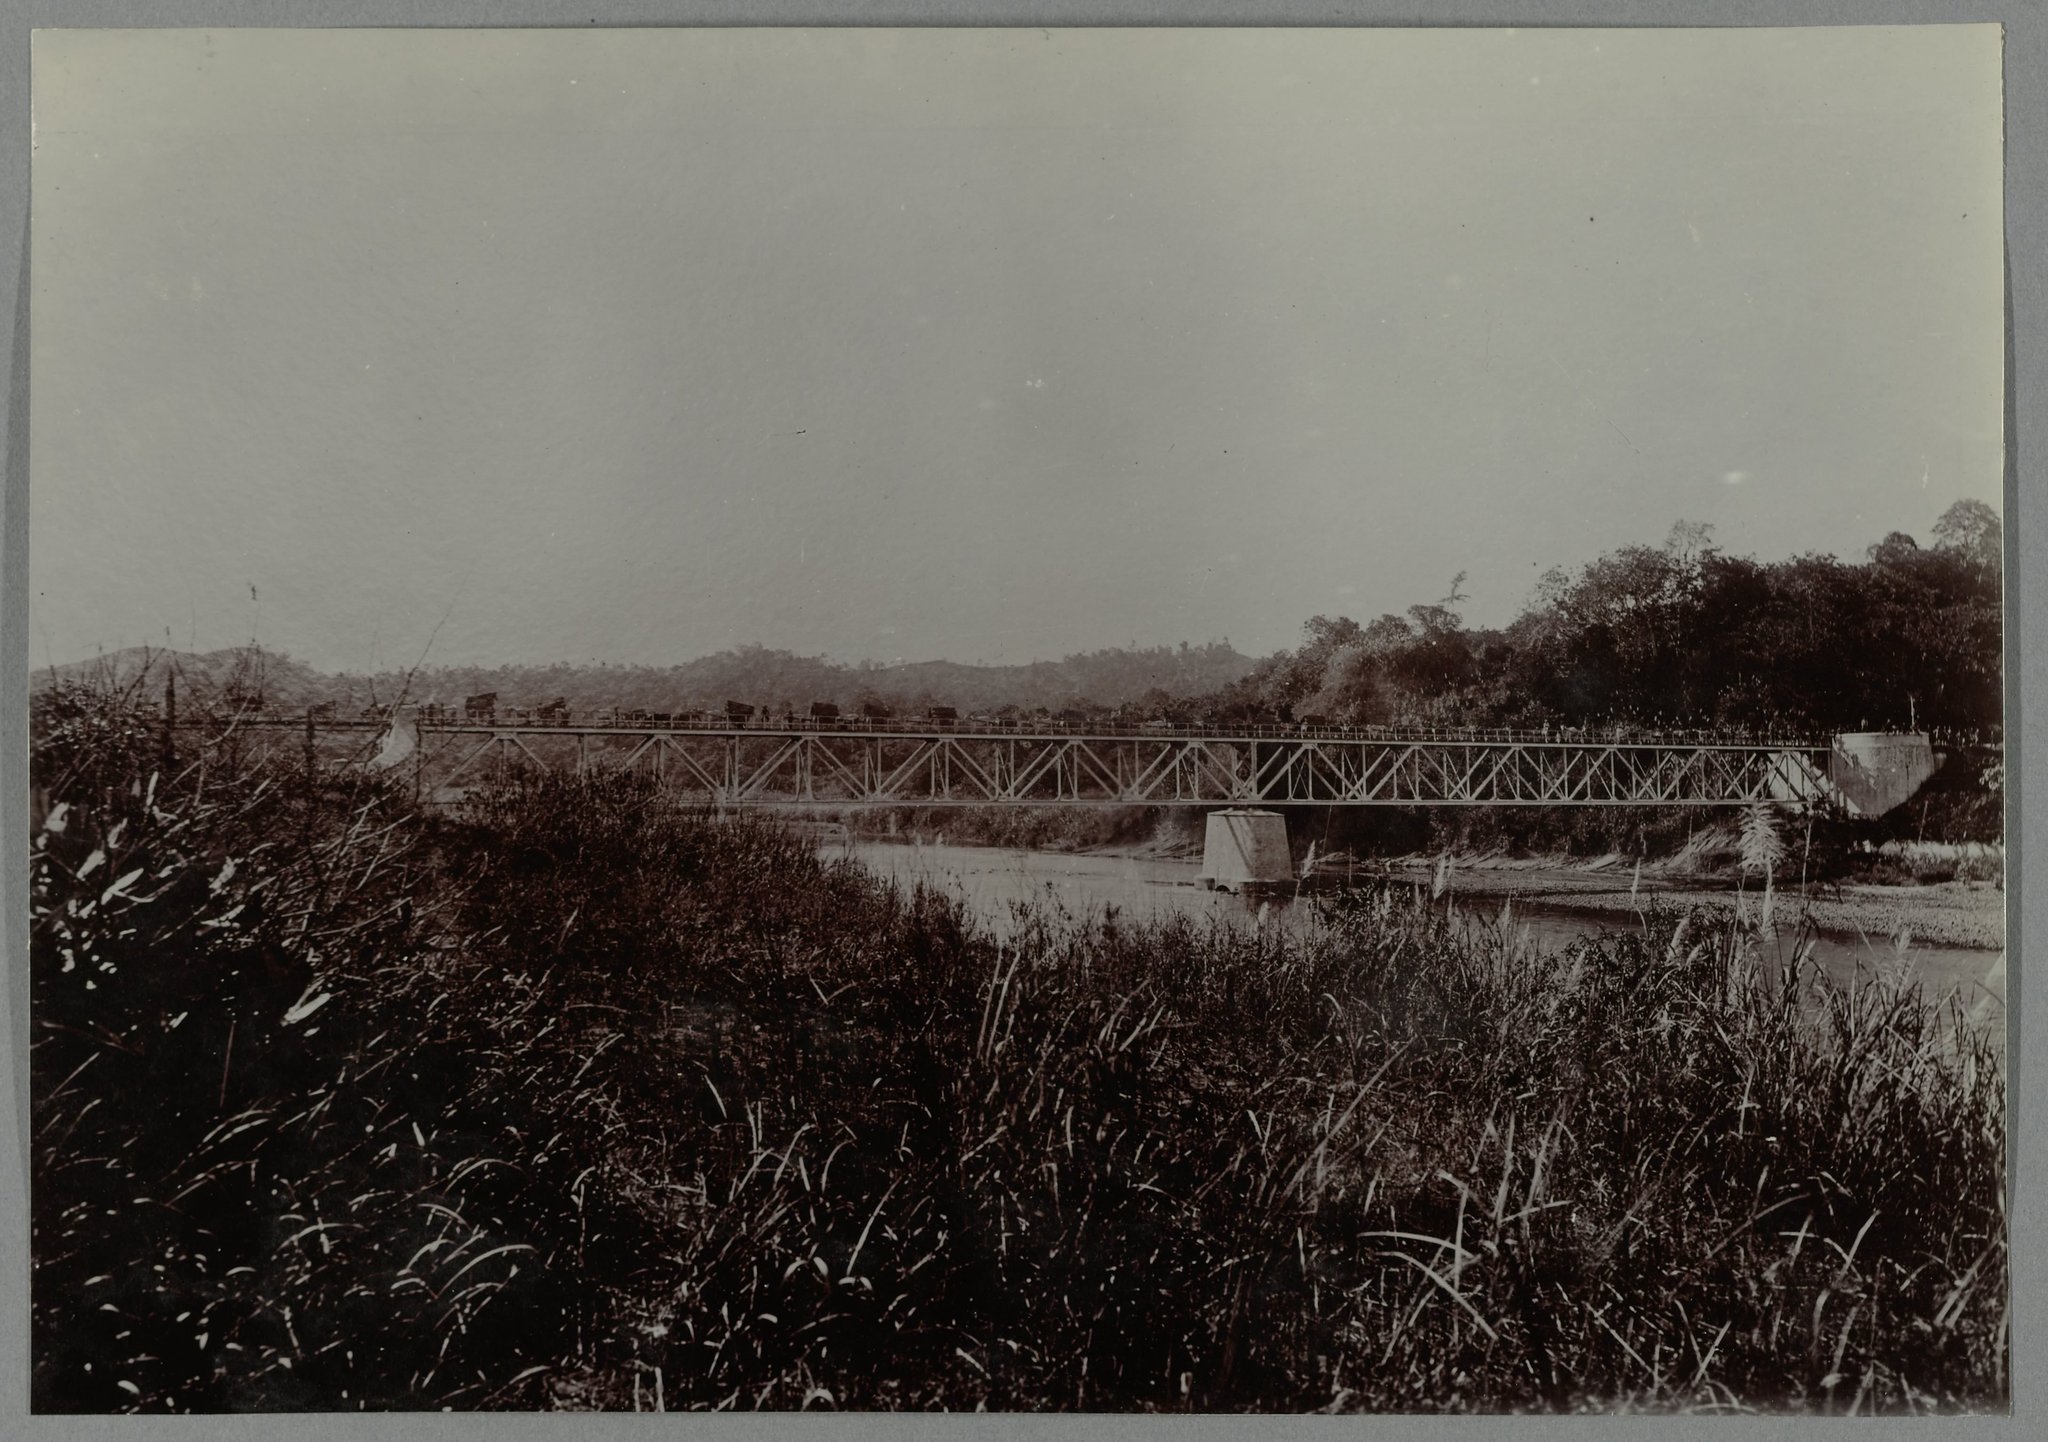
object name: photograph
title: Grote brug bij Teupin Blang Mane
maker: Anonymous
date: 1903-1913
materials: photographic support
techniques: photography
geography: north sumatra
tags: arnhem, the hague, albertus dominicus laman trip, building activities, traffic by road or path with motor-vehicle, landscapes in tropical and sub-tropical regions, road, path, bridge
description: Na de expedities naar de Gajo- en Alaslanden o.l.v. Van Daalen (eerste tocht in 1901), werd hij in 1903 belast met voorbereiding van permanente vestiging van Nederlands gezag. Aanleg van een weg van de Noordkust naar het binnenland was hierbij van groot belang. Deze zgn. Gajoweg werd aangelegd tussen 1903 en 1914, van Bireuen aan de kust naar Takinguen aan het bergmeer Danau Lauttawar, totale lente 104 km.